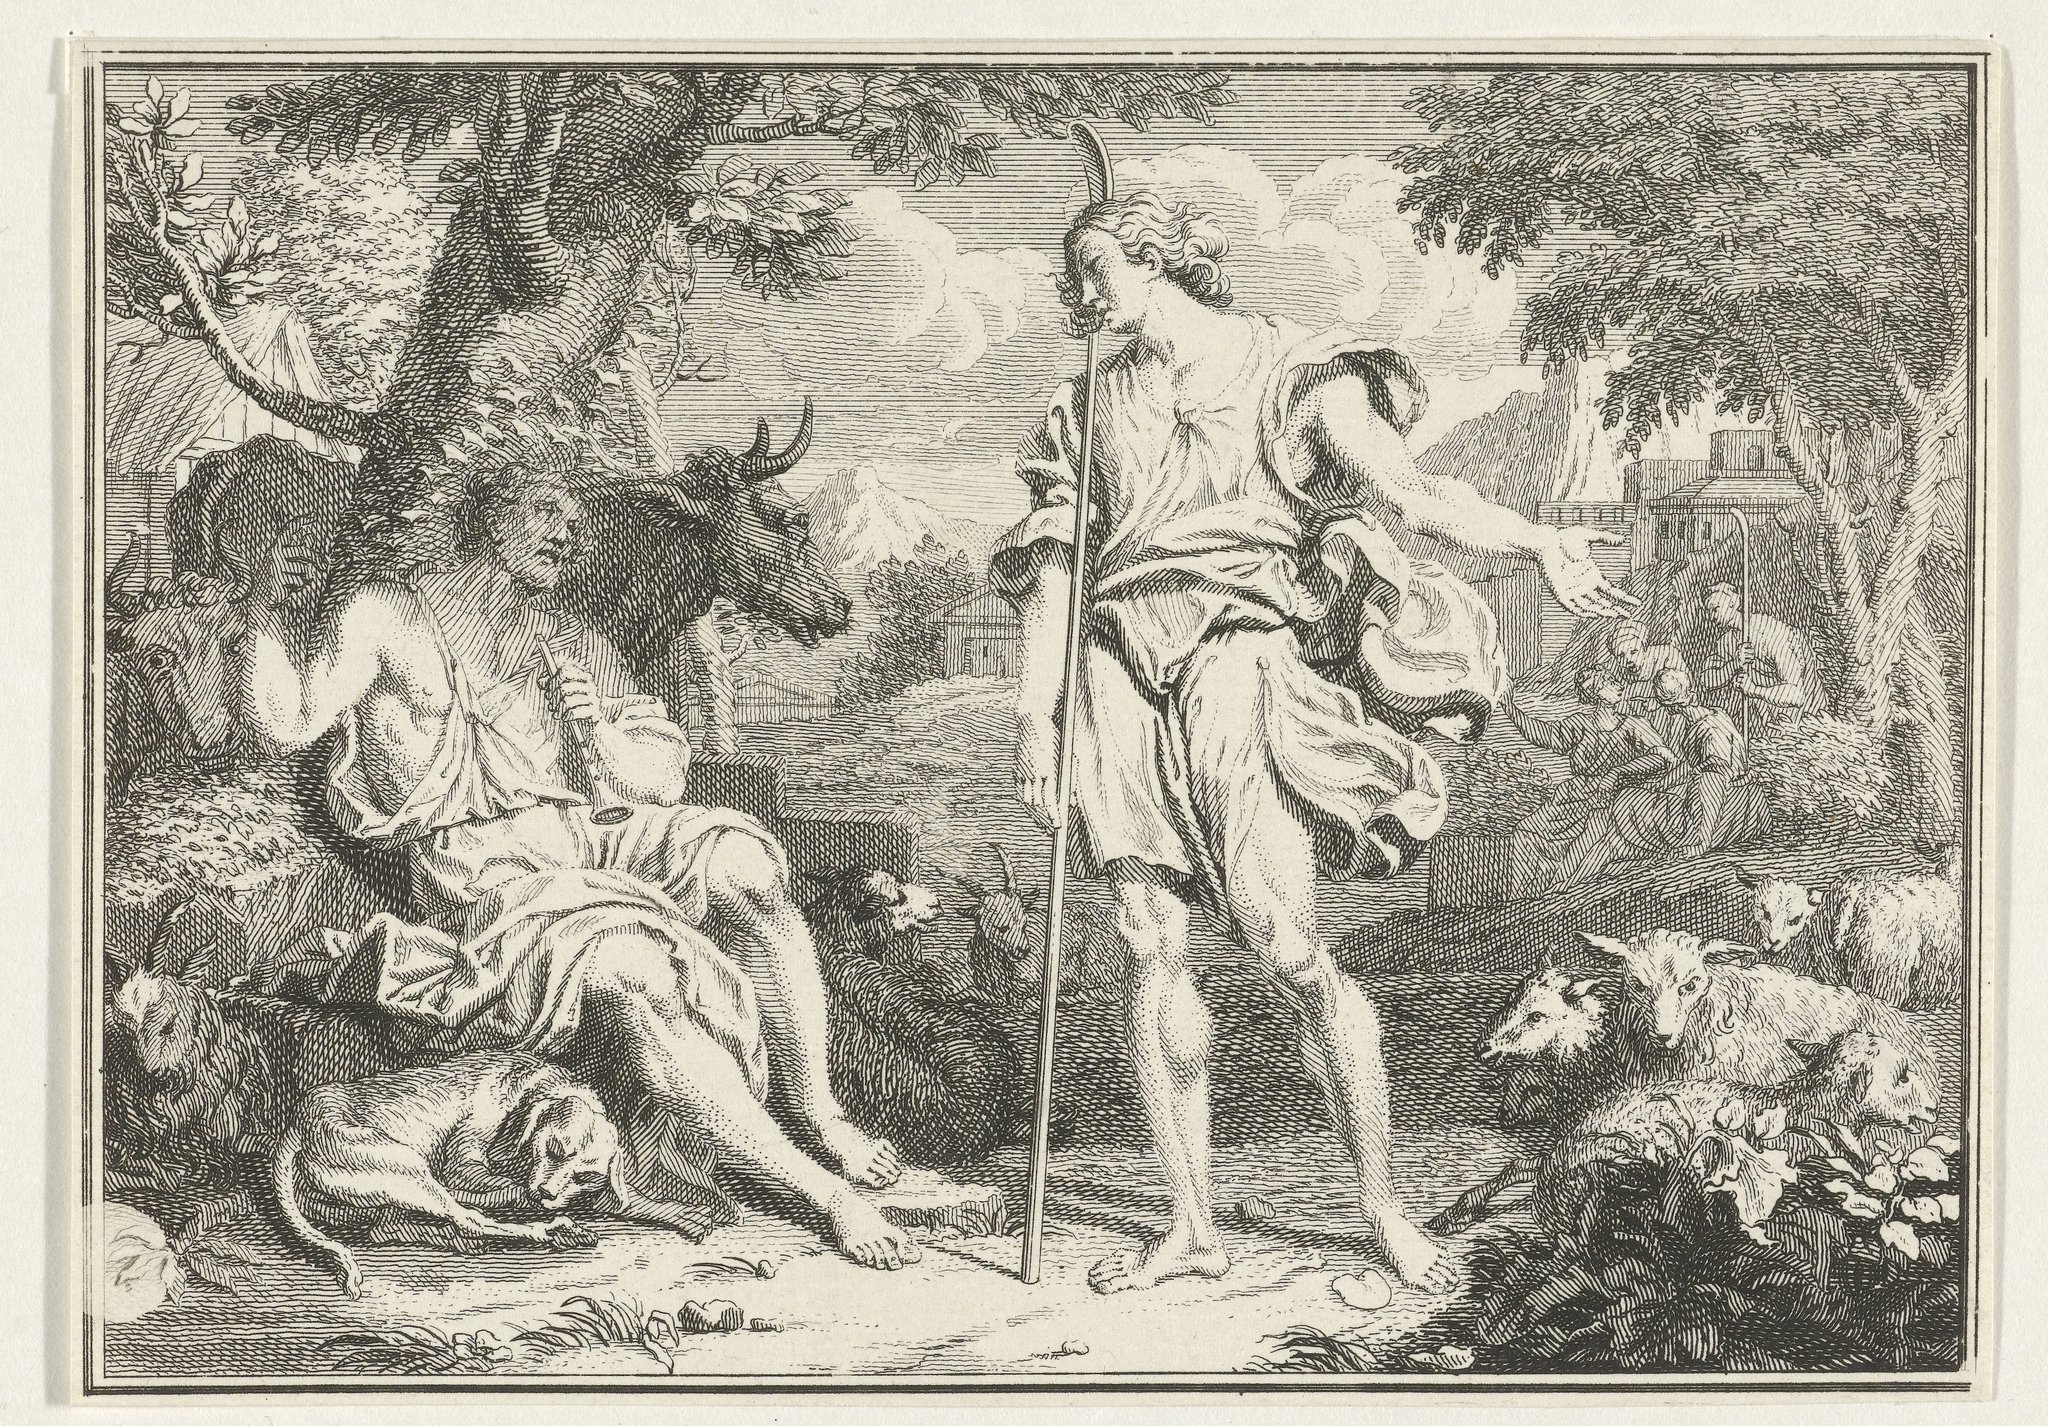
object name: print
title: Voorstellingen uit Vergilius' Bucolia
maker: jacob folkema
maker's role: draughtsman, print maker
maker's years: 1692-1767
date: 1703-1767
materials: paper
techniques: etching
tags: herding, herdsman, herdswoman, shepherd, shepherdess, cowherd, etc.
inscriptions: collector's mark: Lugt 240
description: Omringd door hun vee voeren de twee herders Tityrus en Meliboeus in de buitenlucht een gesprek. Deze illustratie is vervaardigd bij het eerste gedicht uit Vergilius' Bucolica.